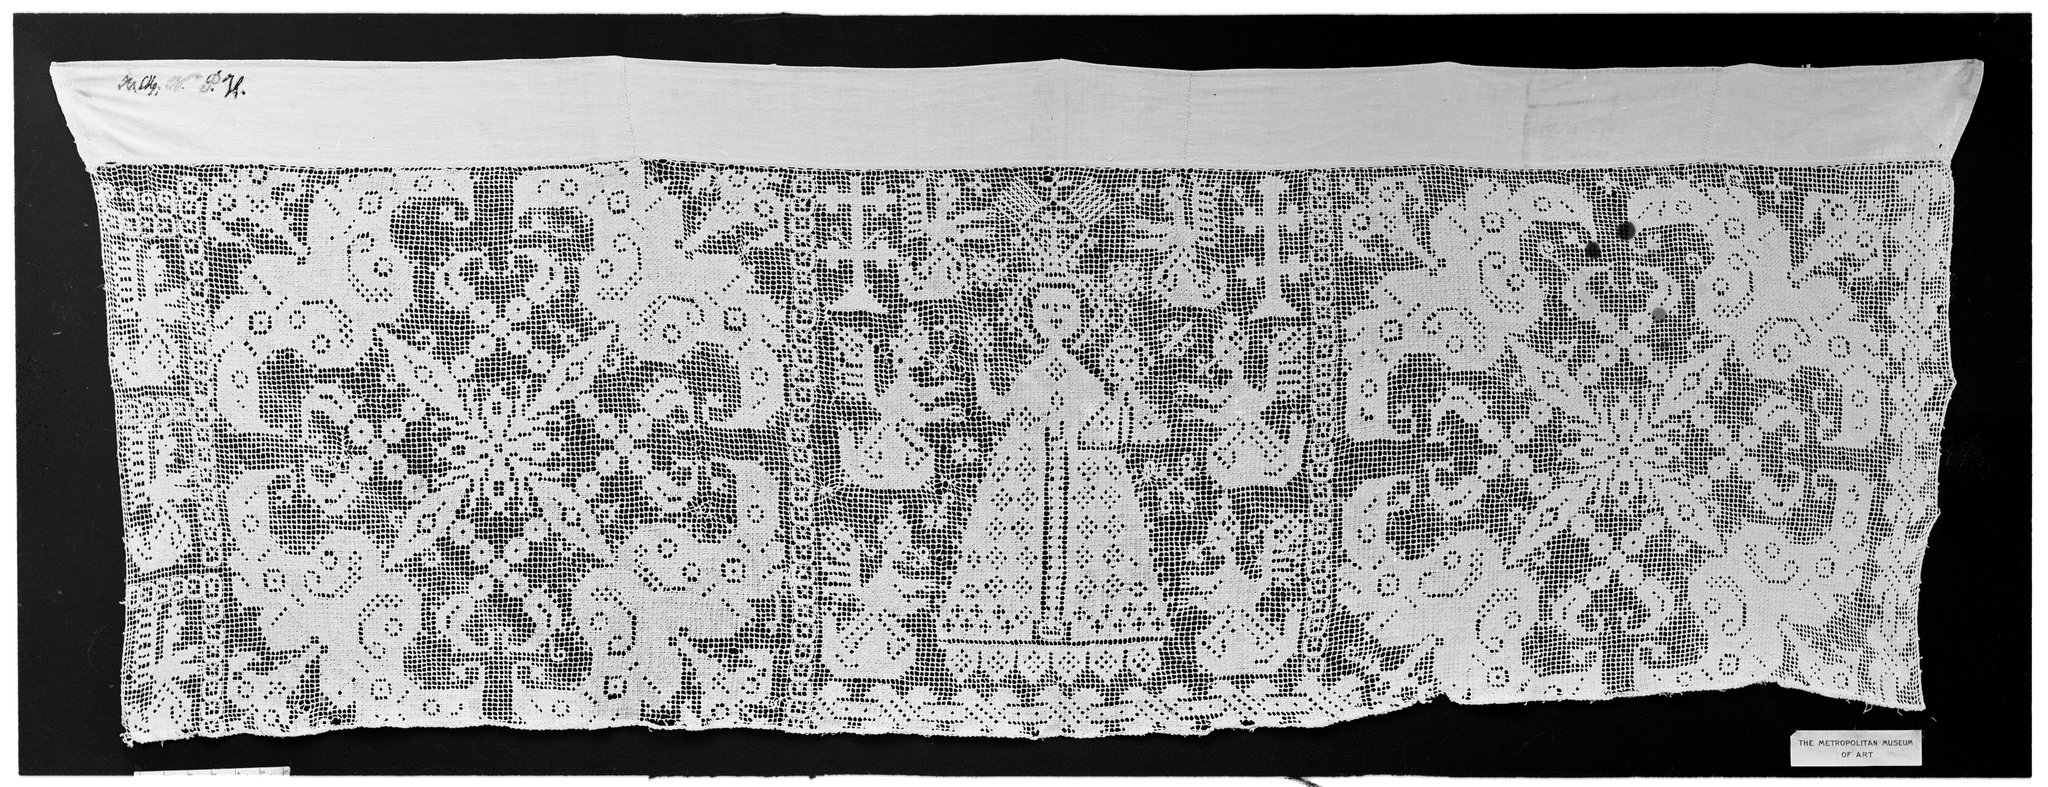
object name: altar frontal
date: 1701-1800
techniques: embroidery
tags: human figures